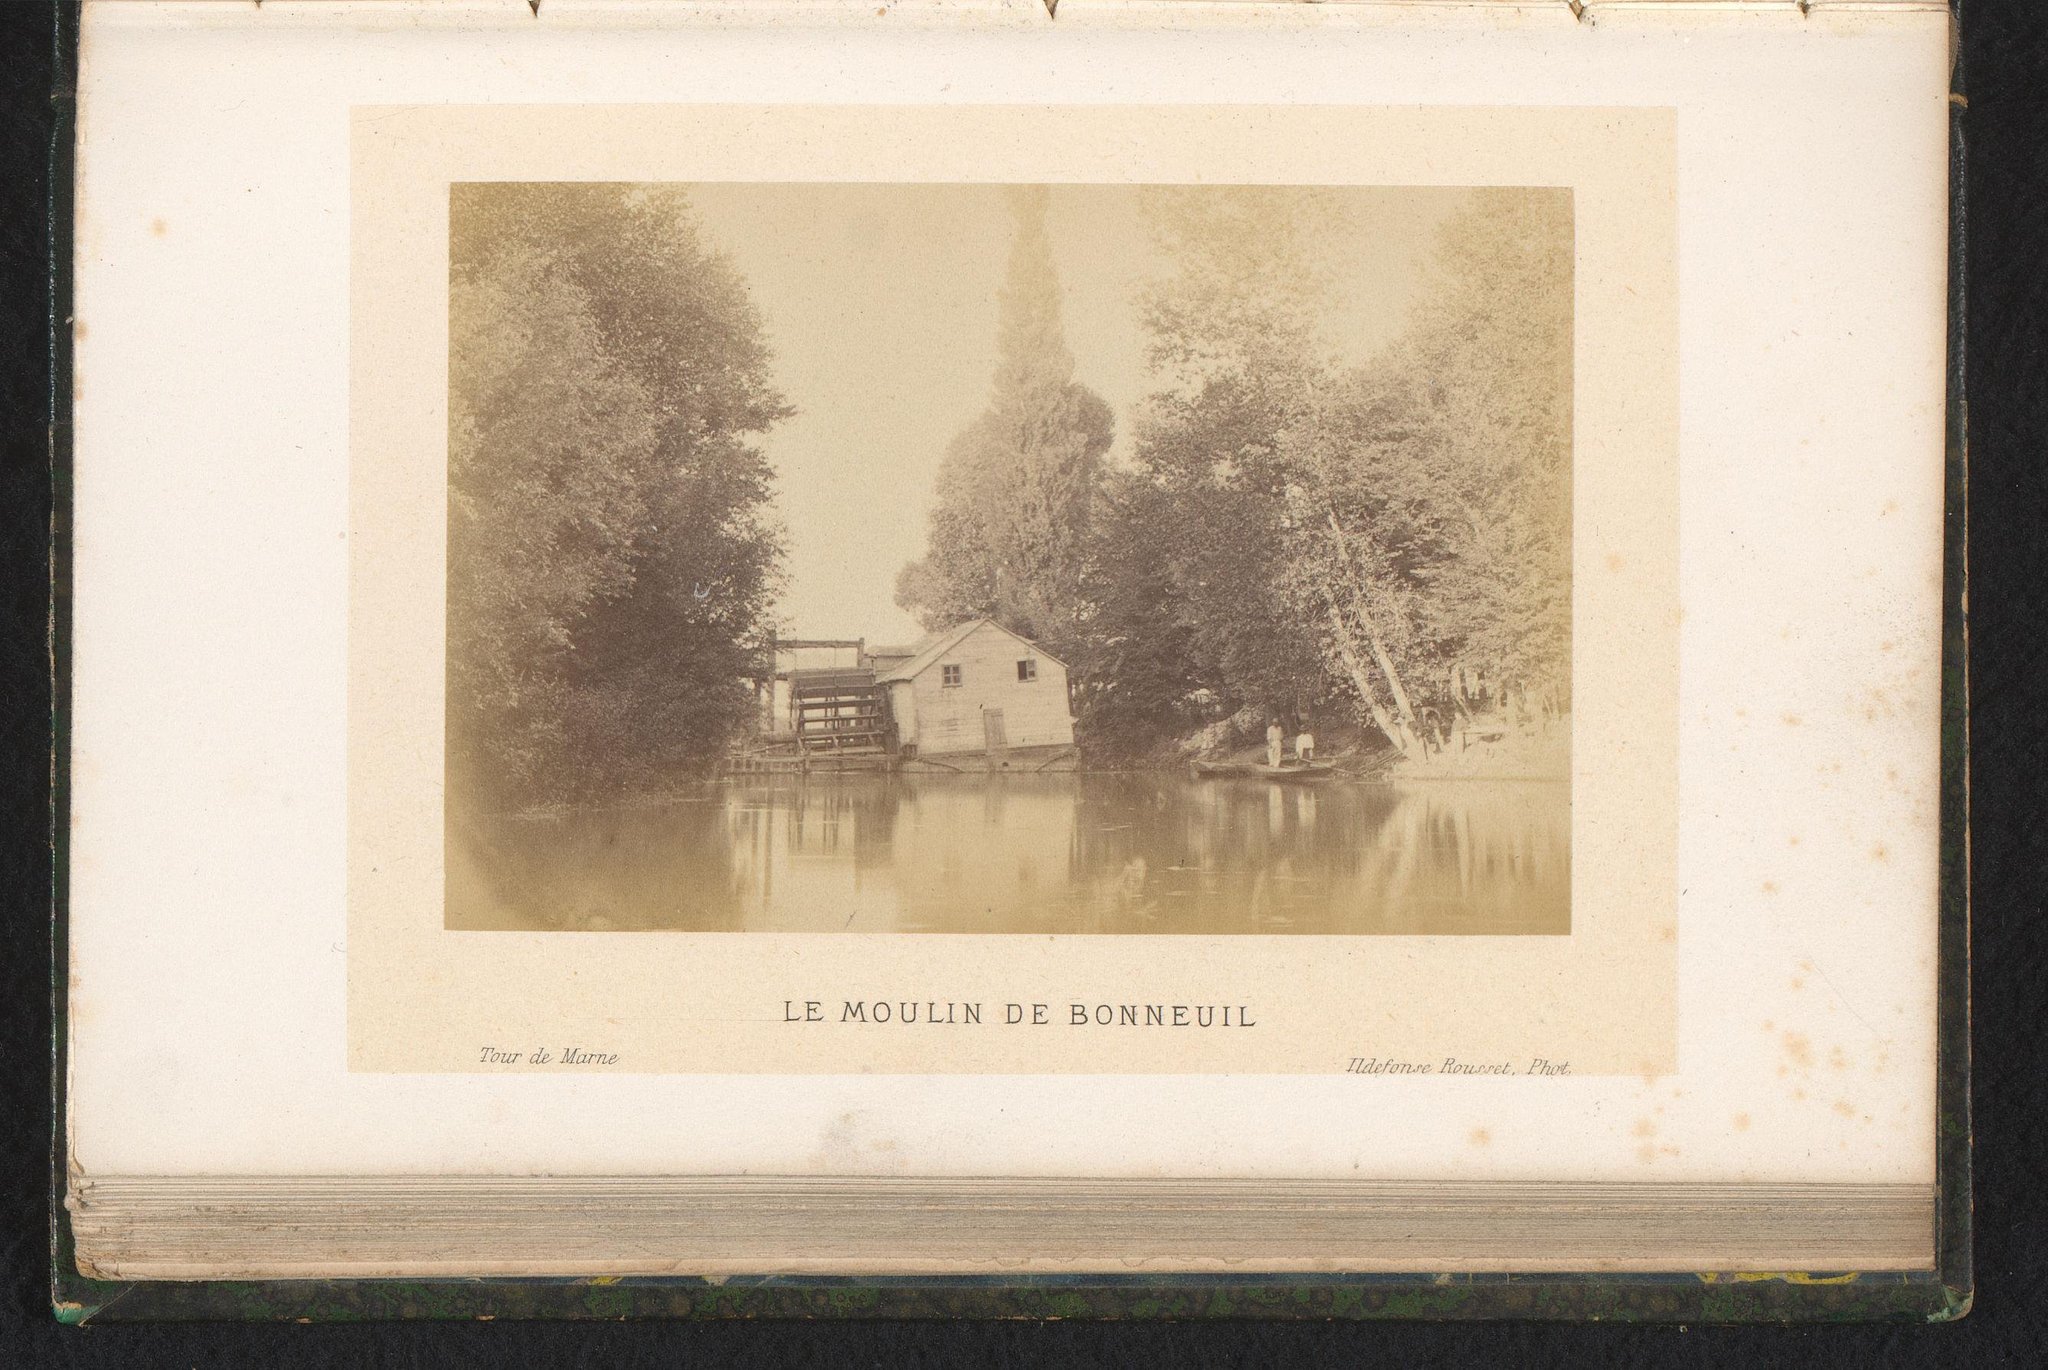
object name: photograph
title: Le moulin de Bonneuil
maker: ildefonse rousset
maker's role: fotograaf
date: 1860-1865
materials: paper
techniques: albumen print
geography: bonneuil-sur-marne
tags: river, watermill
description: Foto op ongenummerde pagina tegenover pagina 100.